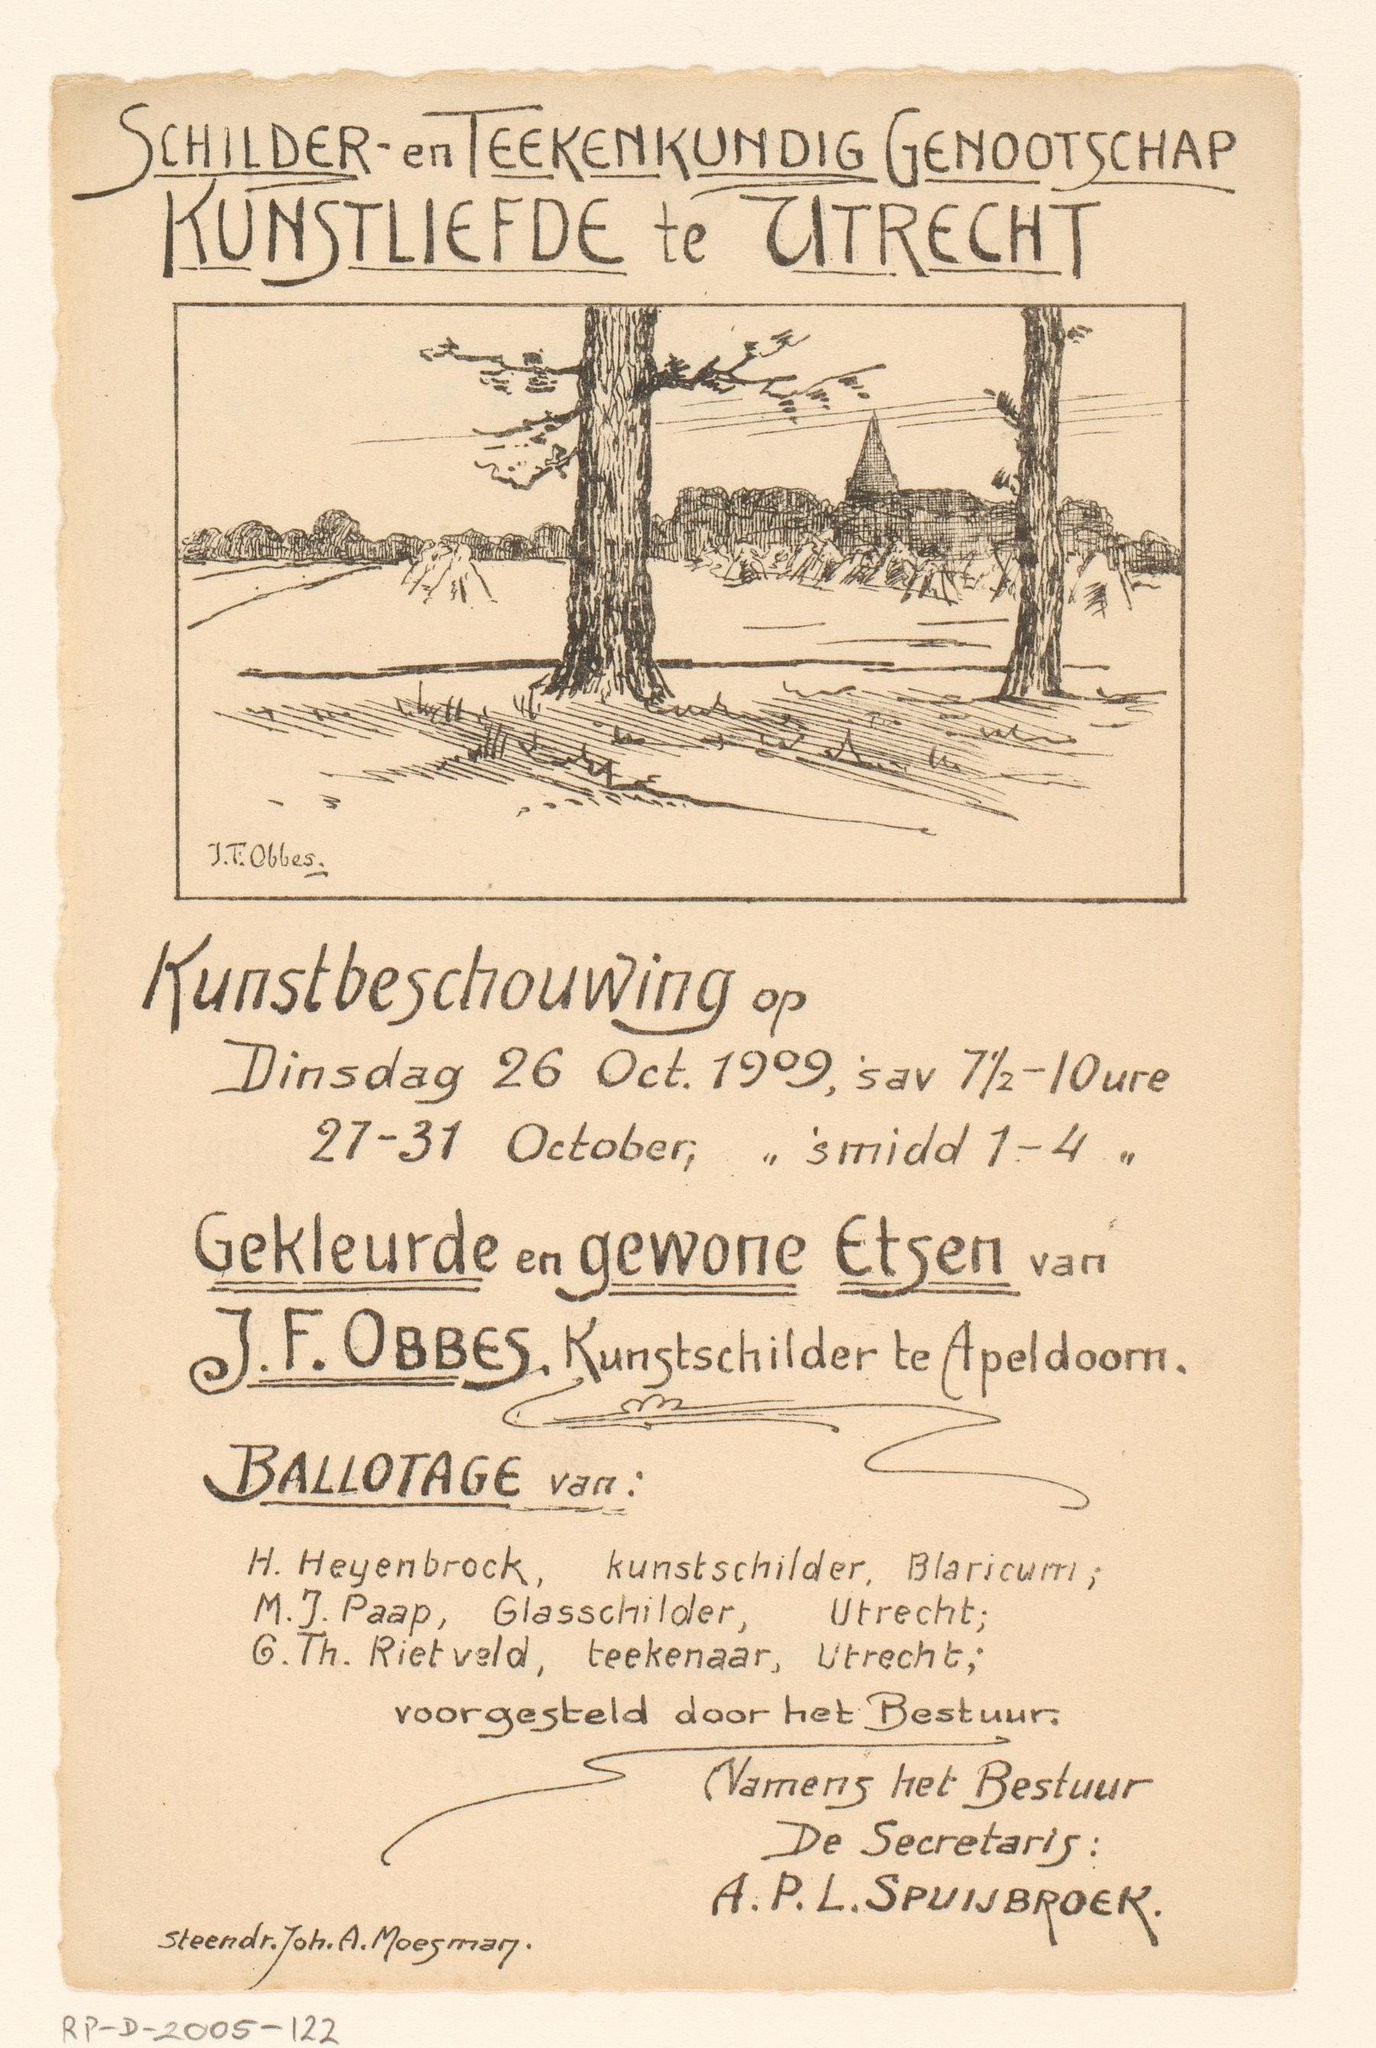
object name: print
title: Uitnodiging van Schilder- en Teekenkundig Genootschap "Kunstliefde" voor een kunstbeschouwing, 26-31 oktober 1909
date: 1909-1910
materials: paper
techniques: lithograph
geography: utrecht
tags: voorschoten, print maker, joan françois obbes, criticizing and discussing art, art criticism, prospect of village, silhouette of village, circle, club of artists, collecting and exhibiting products of the fine arts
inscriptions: collector's mark: Lugt 2228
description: Bomen en dorp. Uitnodiging van Schilder- en Teekenkundig Genootschap "Kunstliefde" voor een kunstbeschouwing op 26-31 oktober 1909 van etsen van J.F. Obbes, kunstschilder te Apeldoorn.